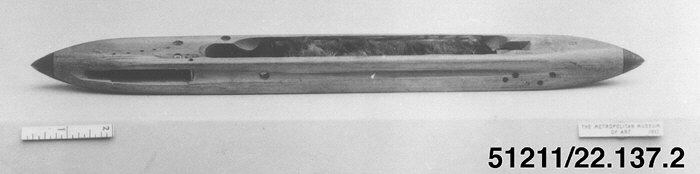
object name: shuttle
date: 1801-1900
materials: wood